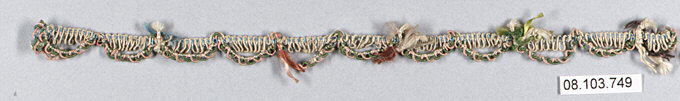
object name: gimp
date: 1734-1766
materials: silk